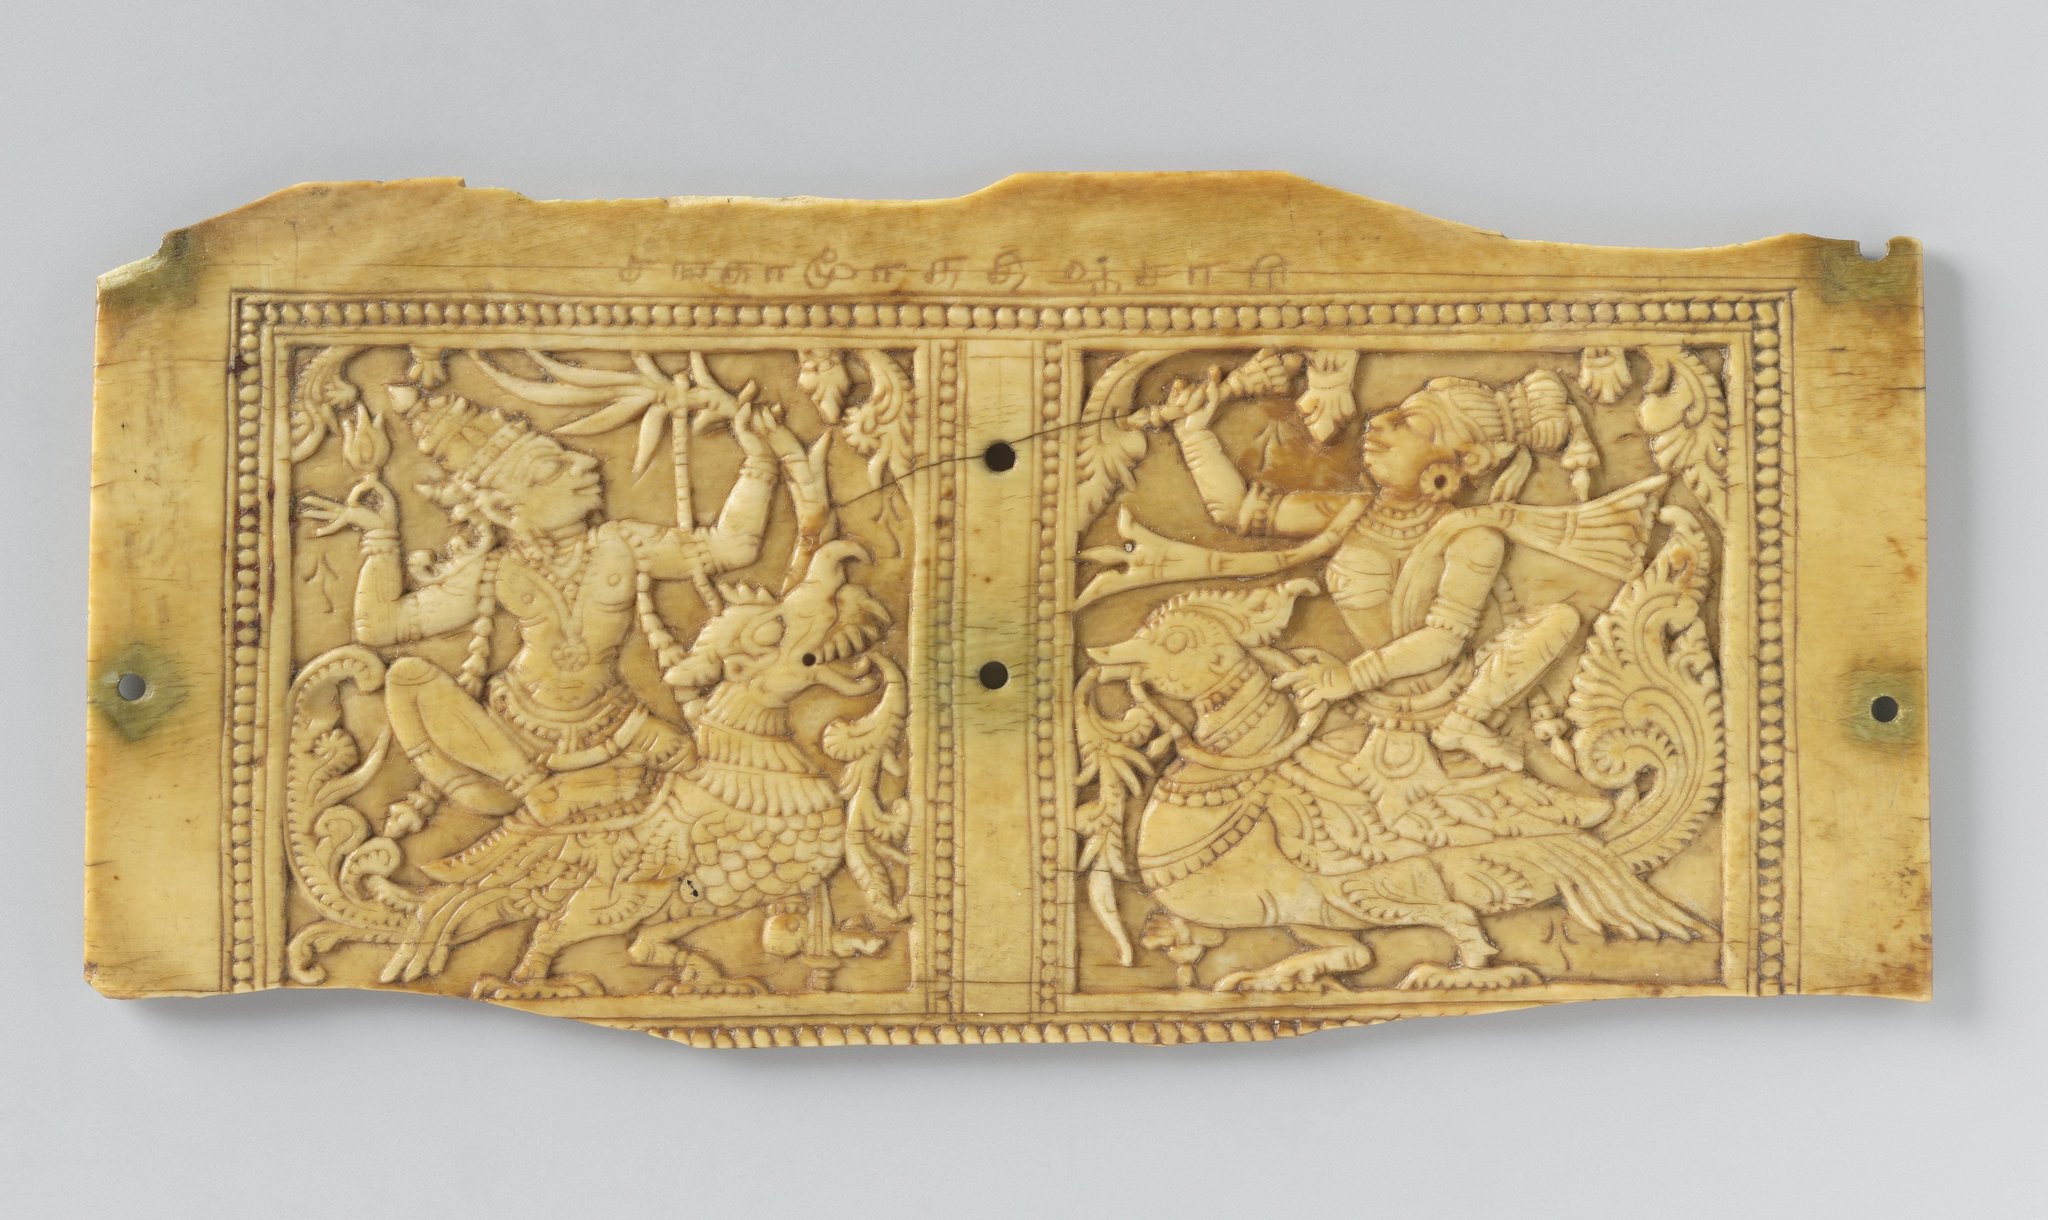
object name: panel ornament area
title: Panel with Kama and Rati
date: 1700-1800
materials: ivory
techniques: cutting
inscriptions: inscription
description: This small panel is unusual because of the inscription at the top, which records either the name of its owner or its maker. Such inscriptions are exceptionally rare in South Asian art.